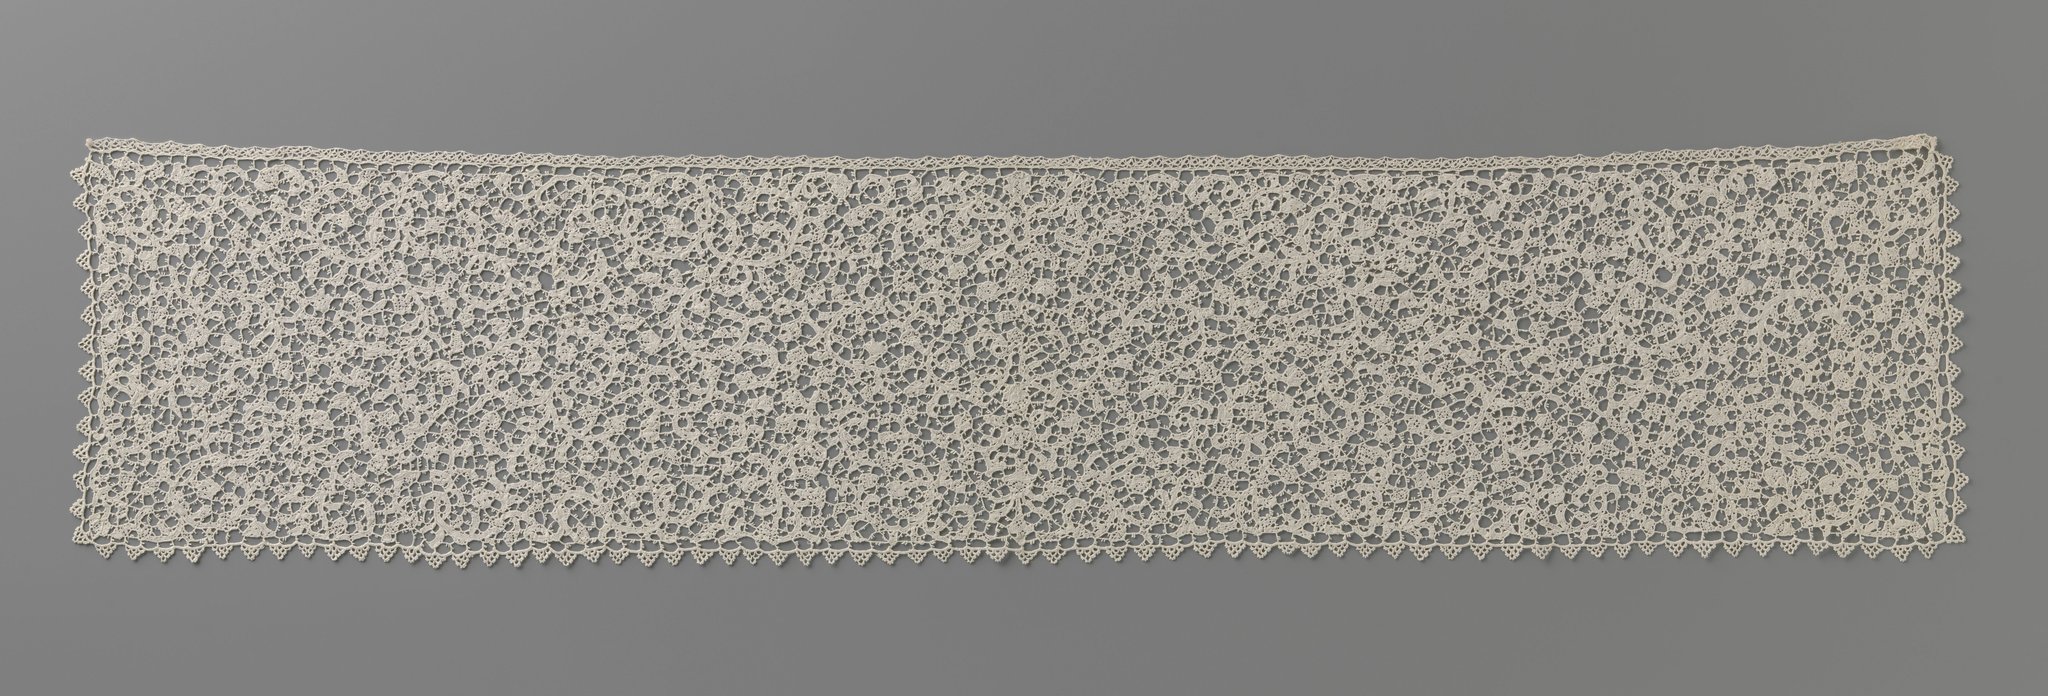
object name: dasslip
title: Dasslip van naaldkant met voluutranken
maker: Anonymous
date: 1675-1699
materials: linen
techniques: flat venetian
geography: venice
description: Dasslip van naturelkleurige naaldkant: platte Venetiaanse kant. Symmetrische kant met een onregelmatige spijlengrond, geheel overdekt met dikke voluutranken waaraan knotsvormige knopjes. Rondom loopt een rechte lijst met gelijkvormige driehoeken van boogjes.